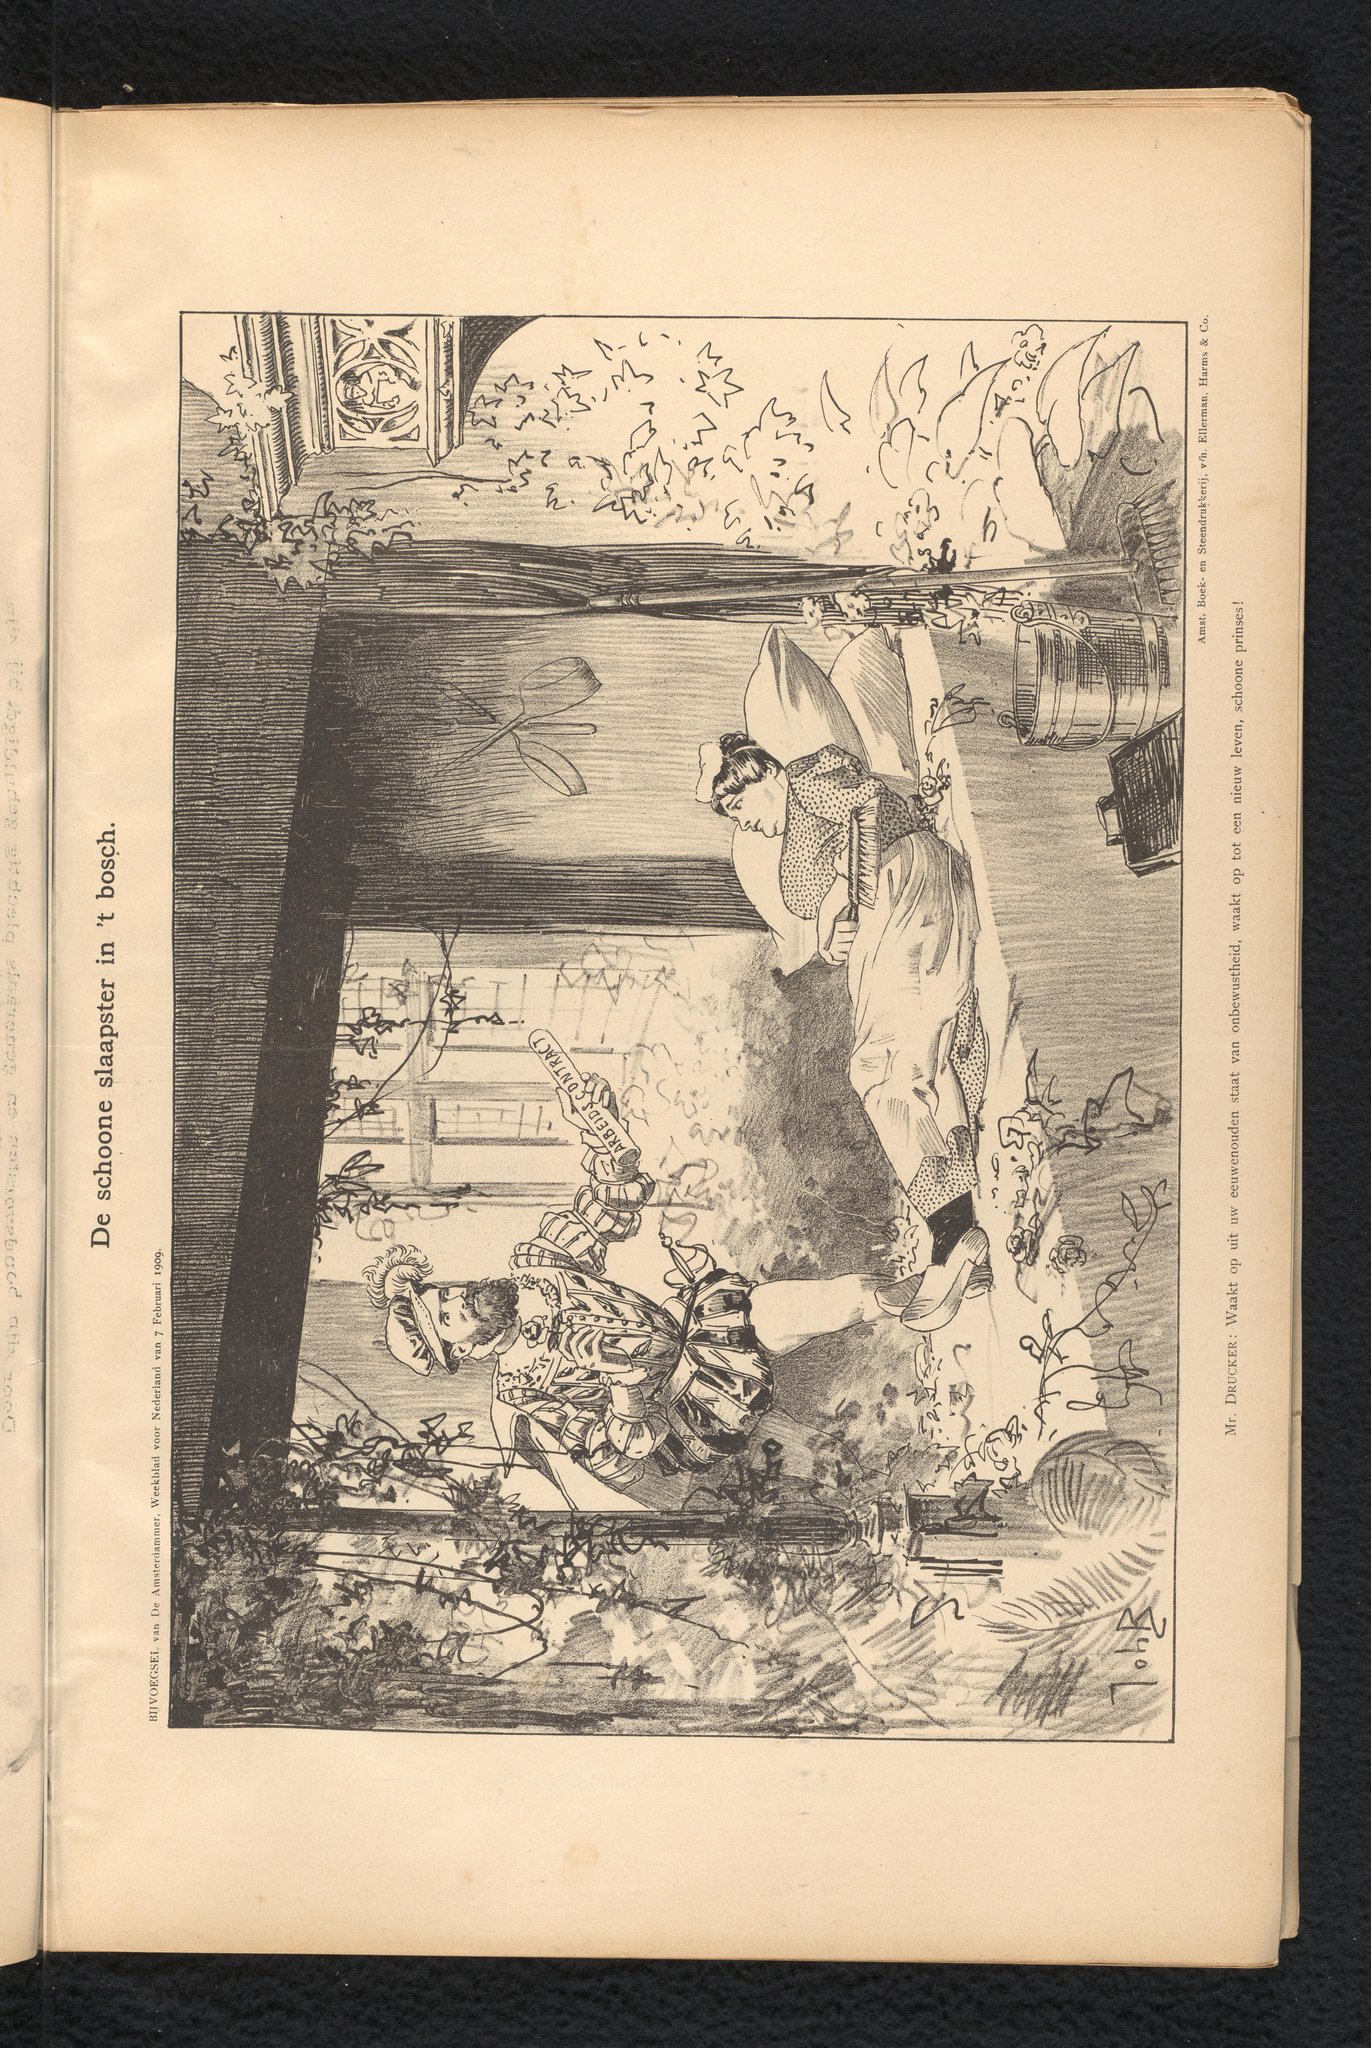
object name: cartoon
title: De schoone slaapster in 't bosch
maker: johan braakensiek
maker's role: draughtsman, print maker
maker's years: 1858-1940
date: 1909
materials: paper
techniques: lithograph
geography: netherlands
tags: amsterdam, the hague, tales and fairy tales: sleeping beauty, maid ~ house personnel, working class, labourers - aa - women, political caricatures and satires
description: Pastiche op het sprookje van de schone slaapster, waarin Hendrik Drucker als een prins de slapende dienstmeid in een hemelbed wakker maakt met een arbeidscontract.